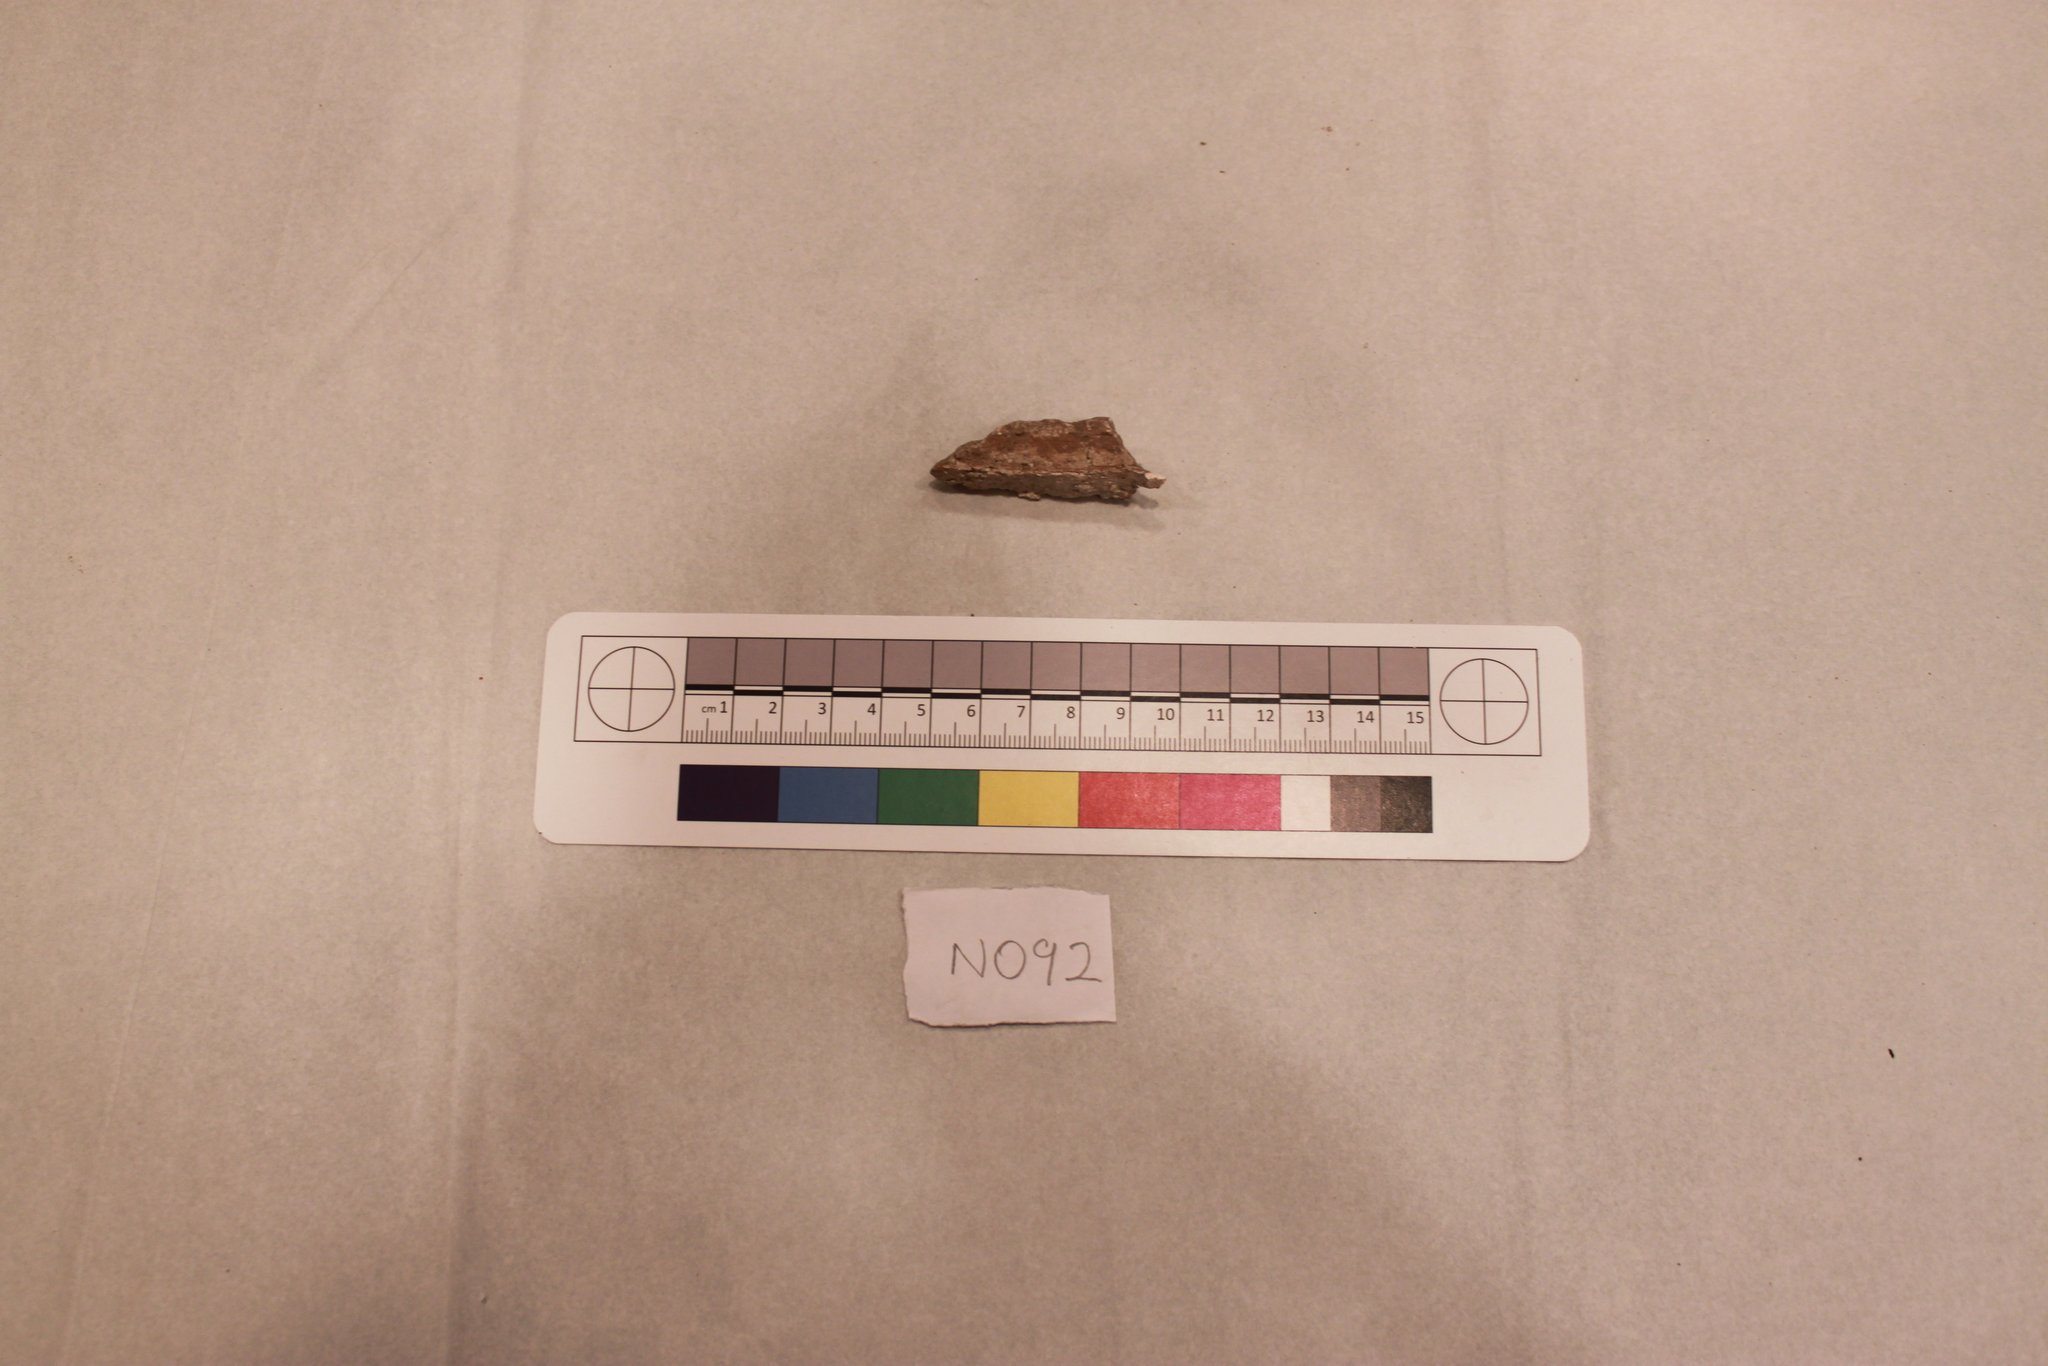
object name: fragment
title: Stucco Fragment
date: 701-1200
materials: plaster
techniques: carving, painting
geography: iran